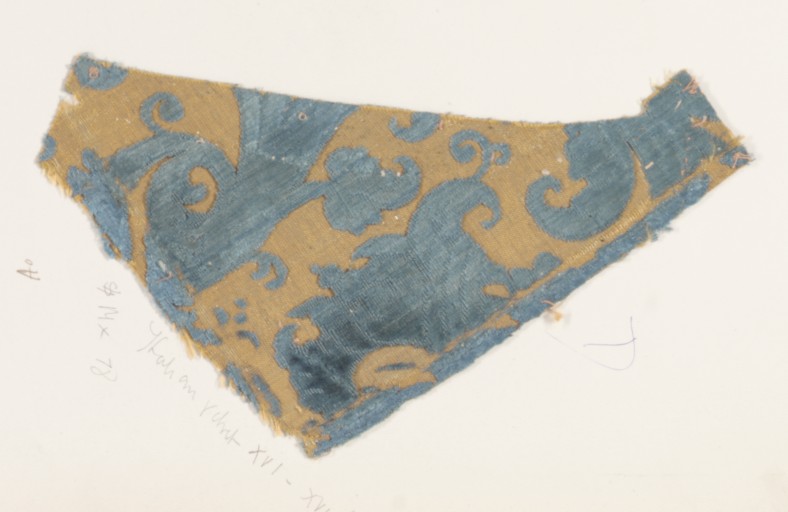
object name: fragment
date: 1501-1700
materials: metal thread, silk